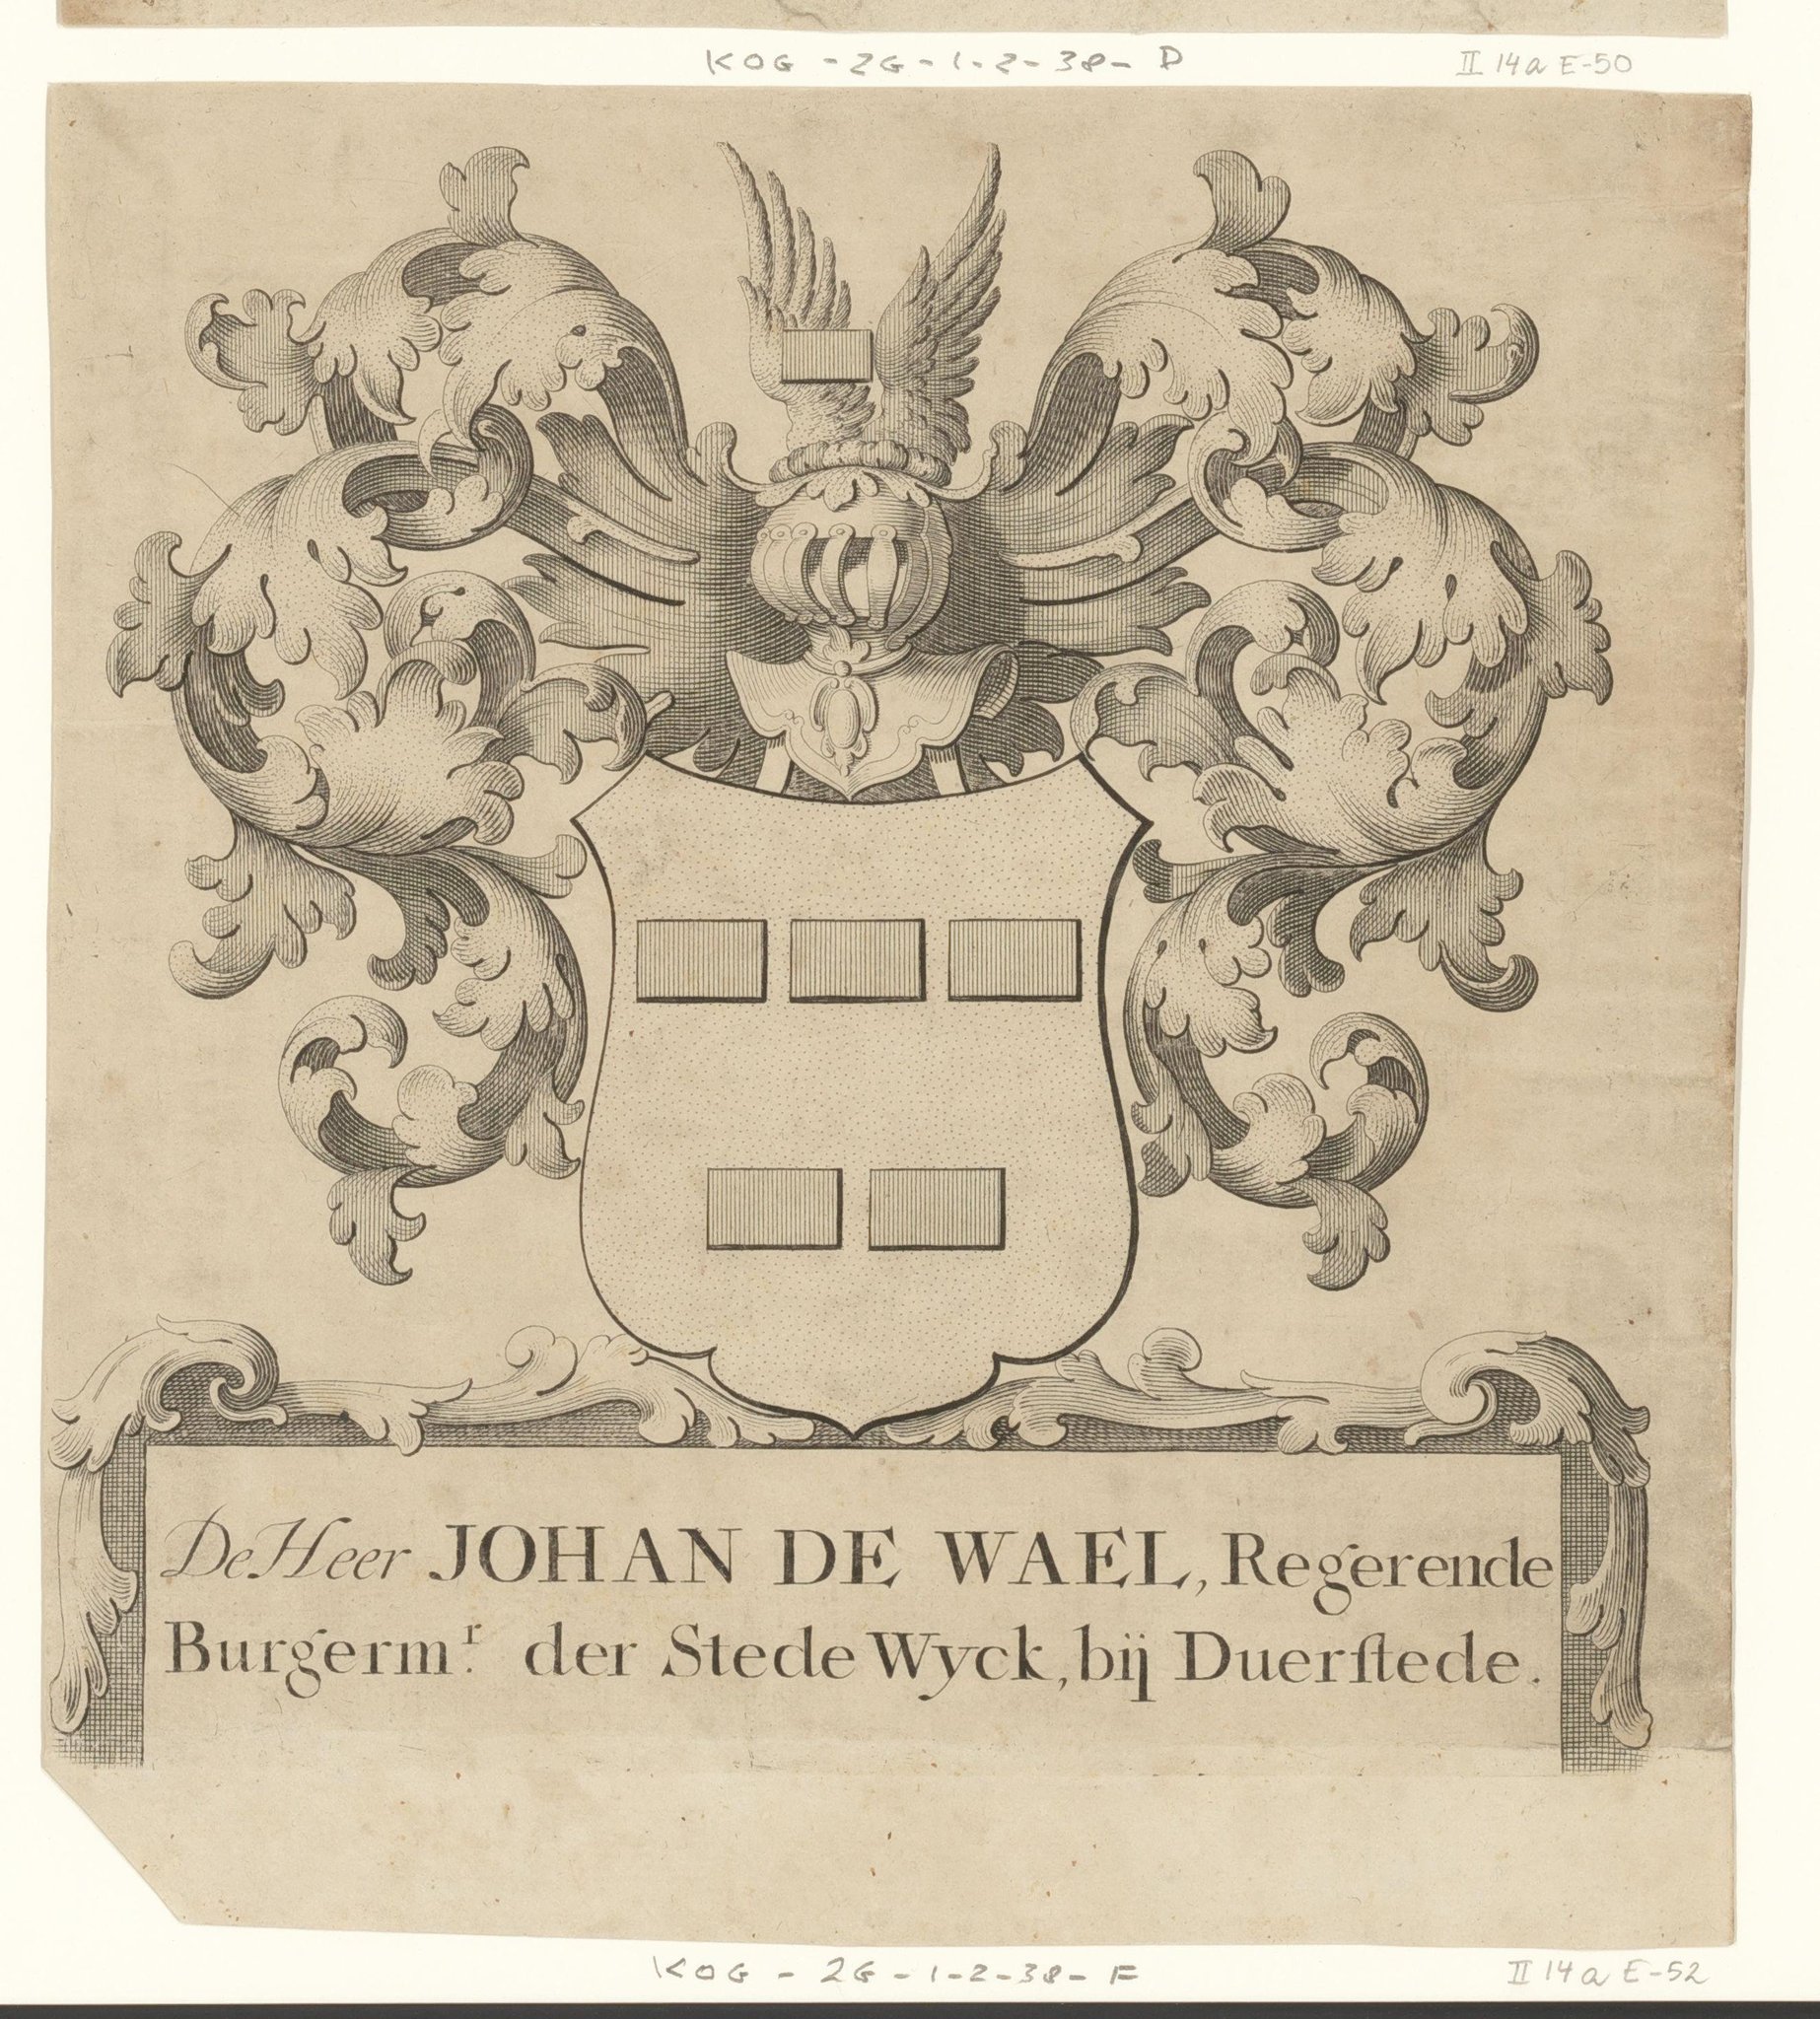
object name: print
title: Familiewapen van Johan de Wael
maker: Anonymous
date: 1689-1690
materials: paper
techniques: engraving, etching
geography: netherlands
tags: mayor, burgomaster, armorial bearing, heraldry, wijk bij duurstede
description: Familiewapen van Johan de Wael, burgemeester van Wijk bij Duurstede. Onderdeel van een groep van twaalf wapens van magistraten van Utrecht. Mogelijk behorend bij een grote kaart van bijvoorbeeld een hoogheemraadschap. Onderwerpsrubrieken binnen de Atlas Zeden en Gewoonten: Regeering, Wapens (Heraldiek), Geslachtswapens.